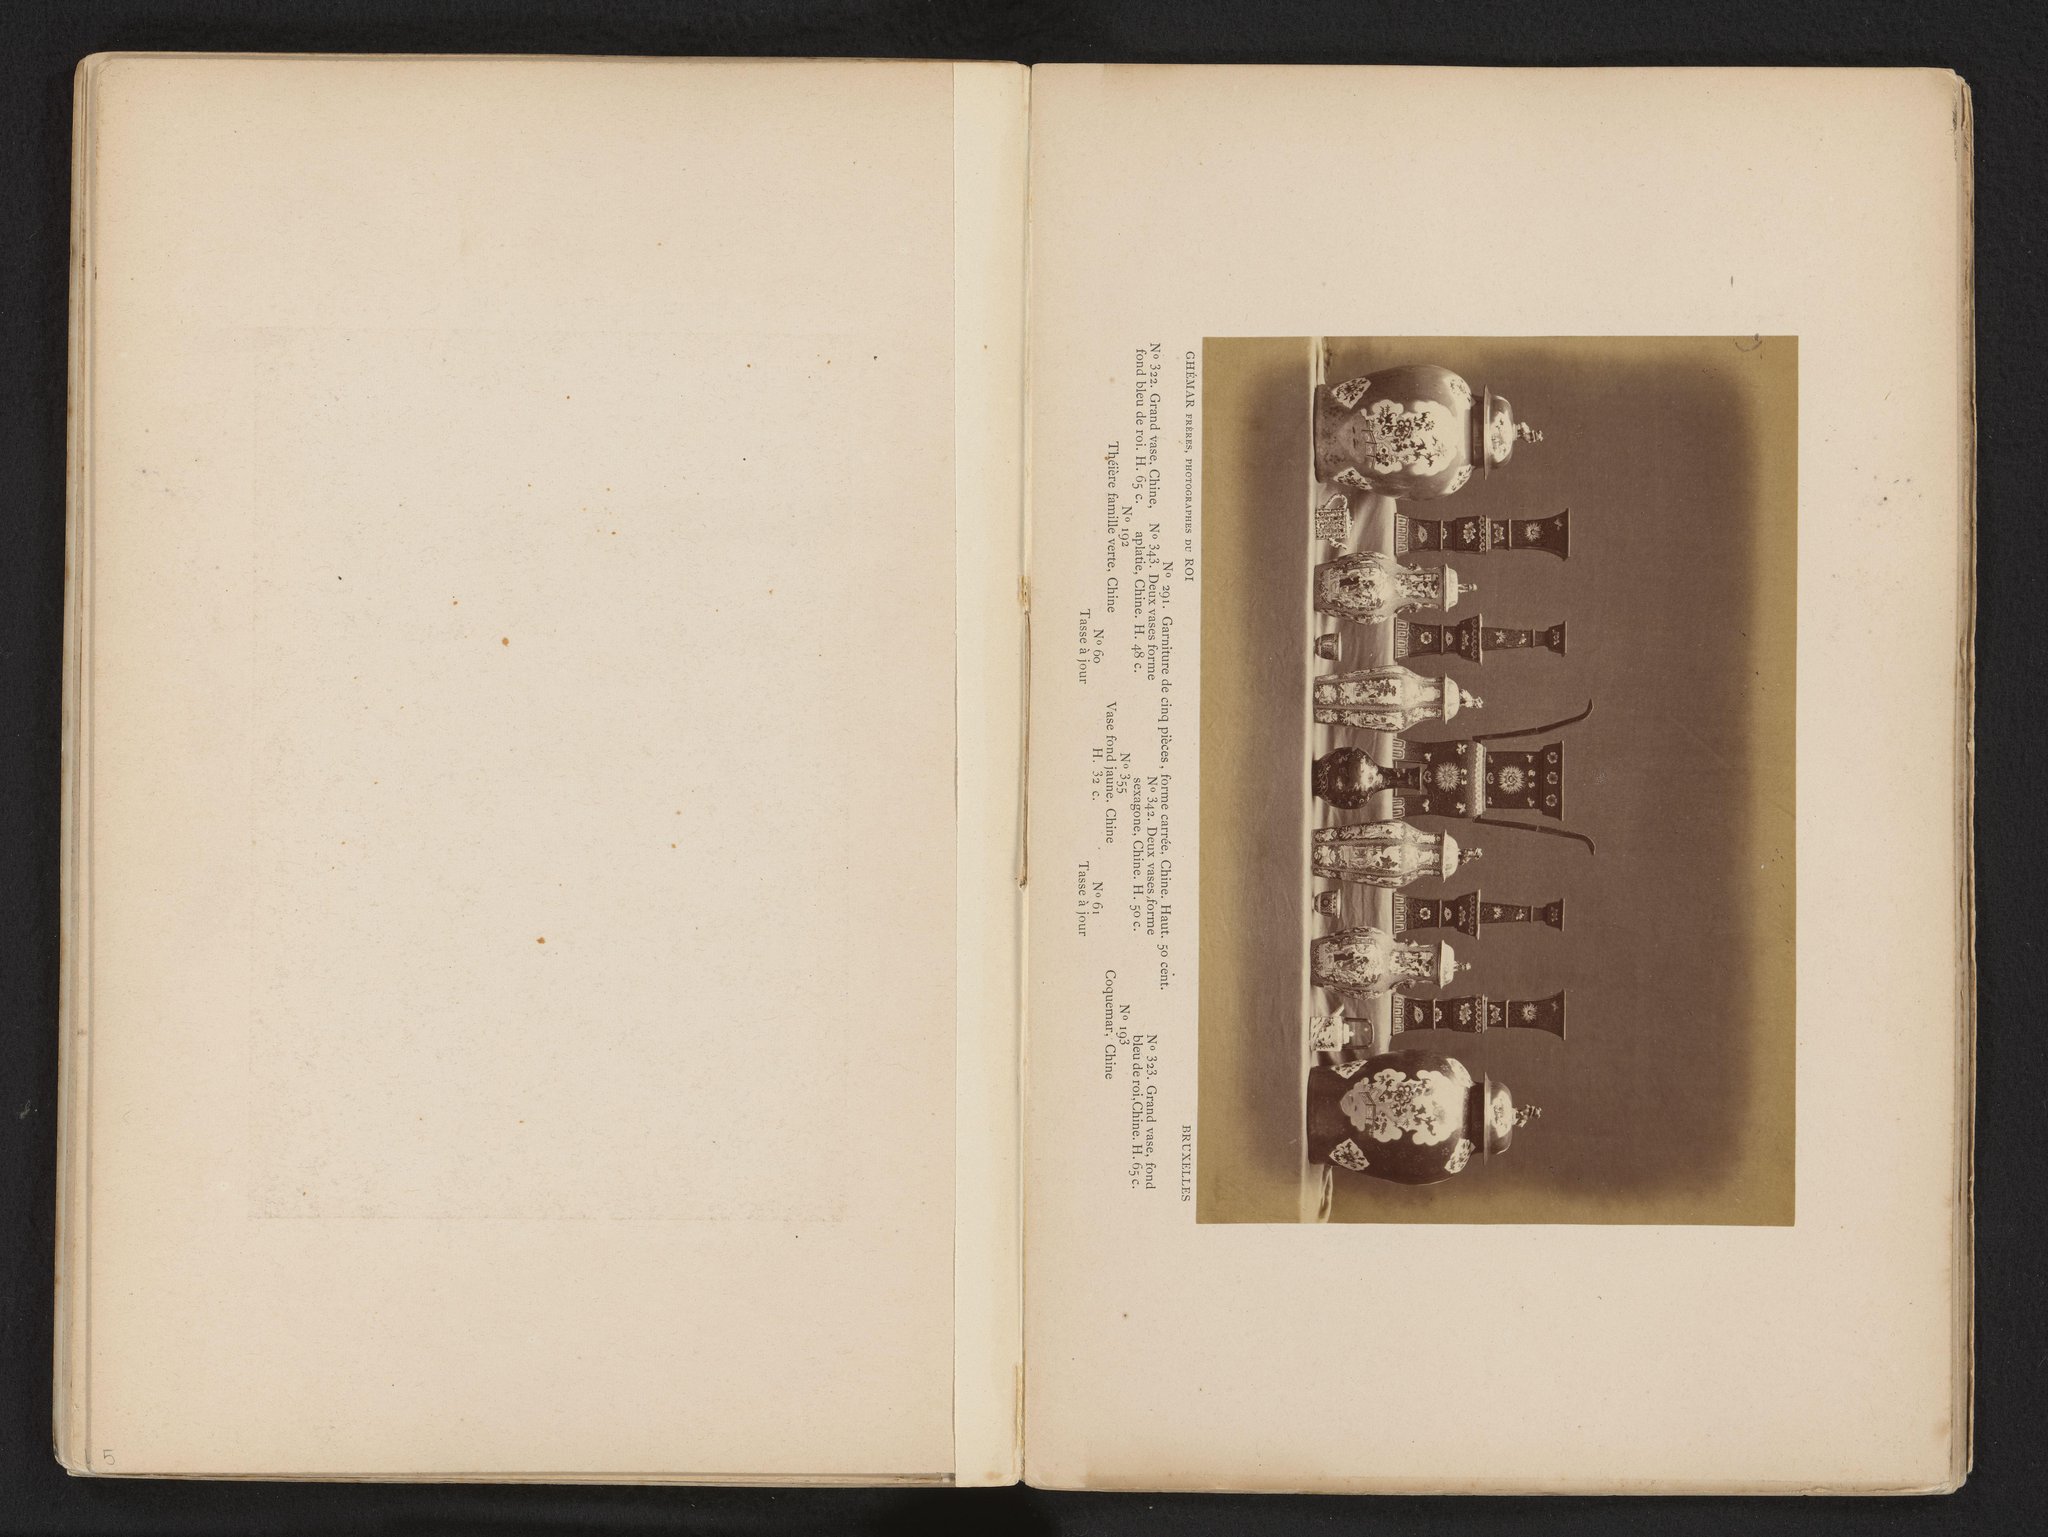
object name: photograph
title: Zestien objecten, waaronder Chinese vazen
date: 1870-1875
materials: photographic support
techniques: albumen print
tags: container of ceramics: jar, jug, pot, vase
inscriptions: inscription: ‘No. 322. Grand vase, Chine, fon bleu de roi. H. 65 c. (...)’